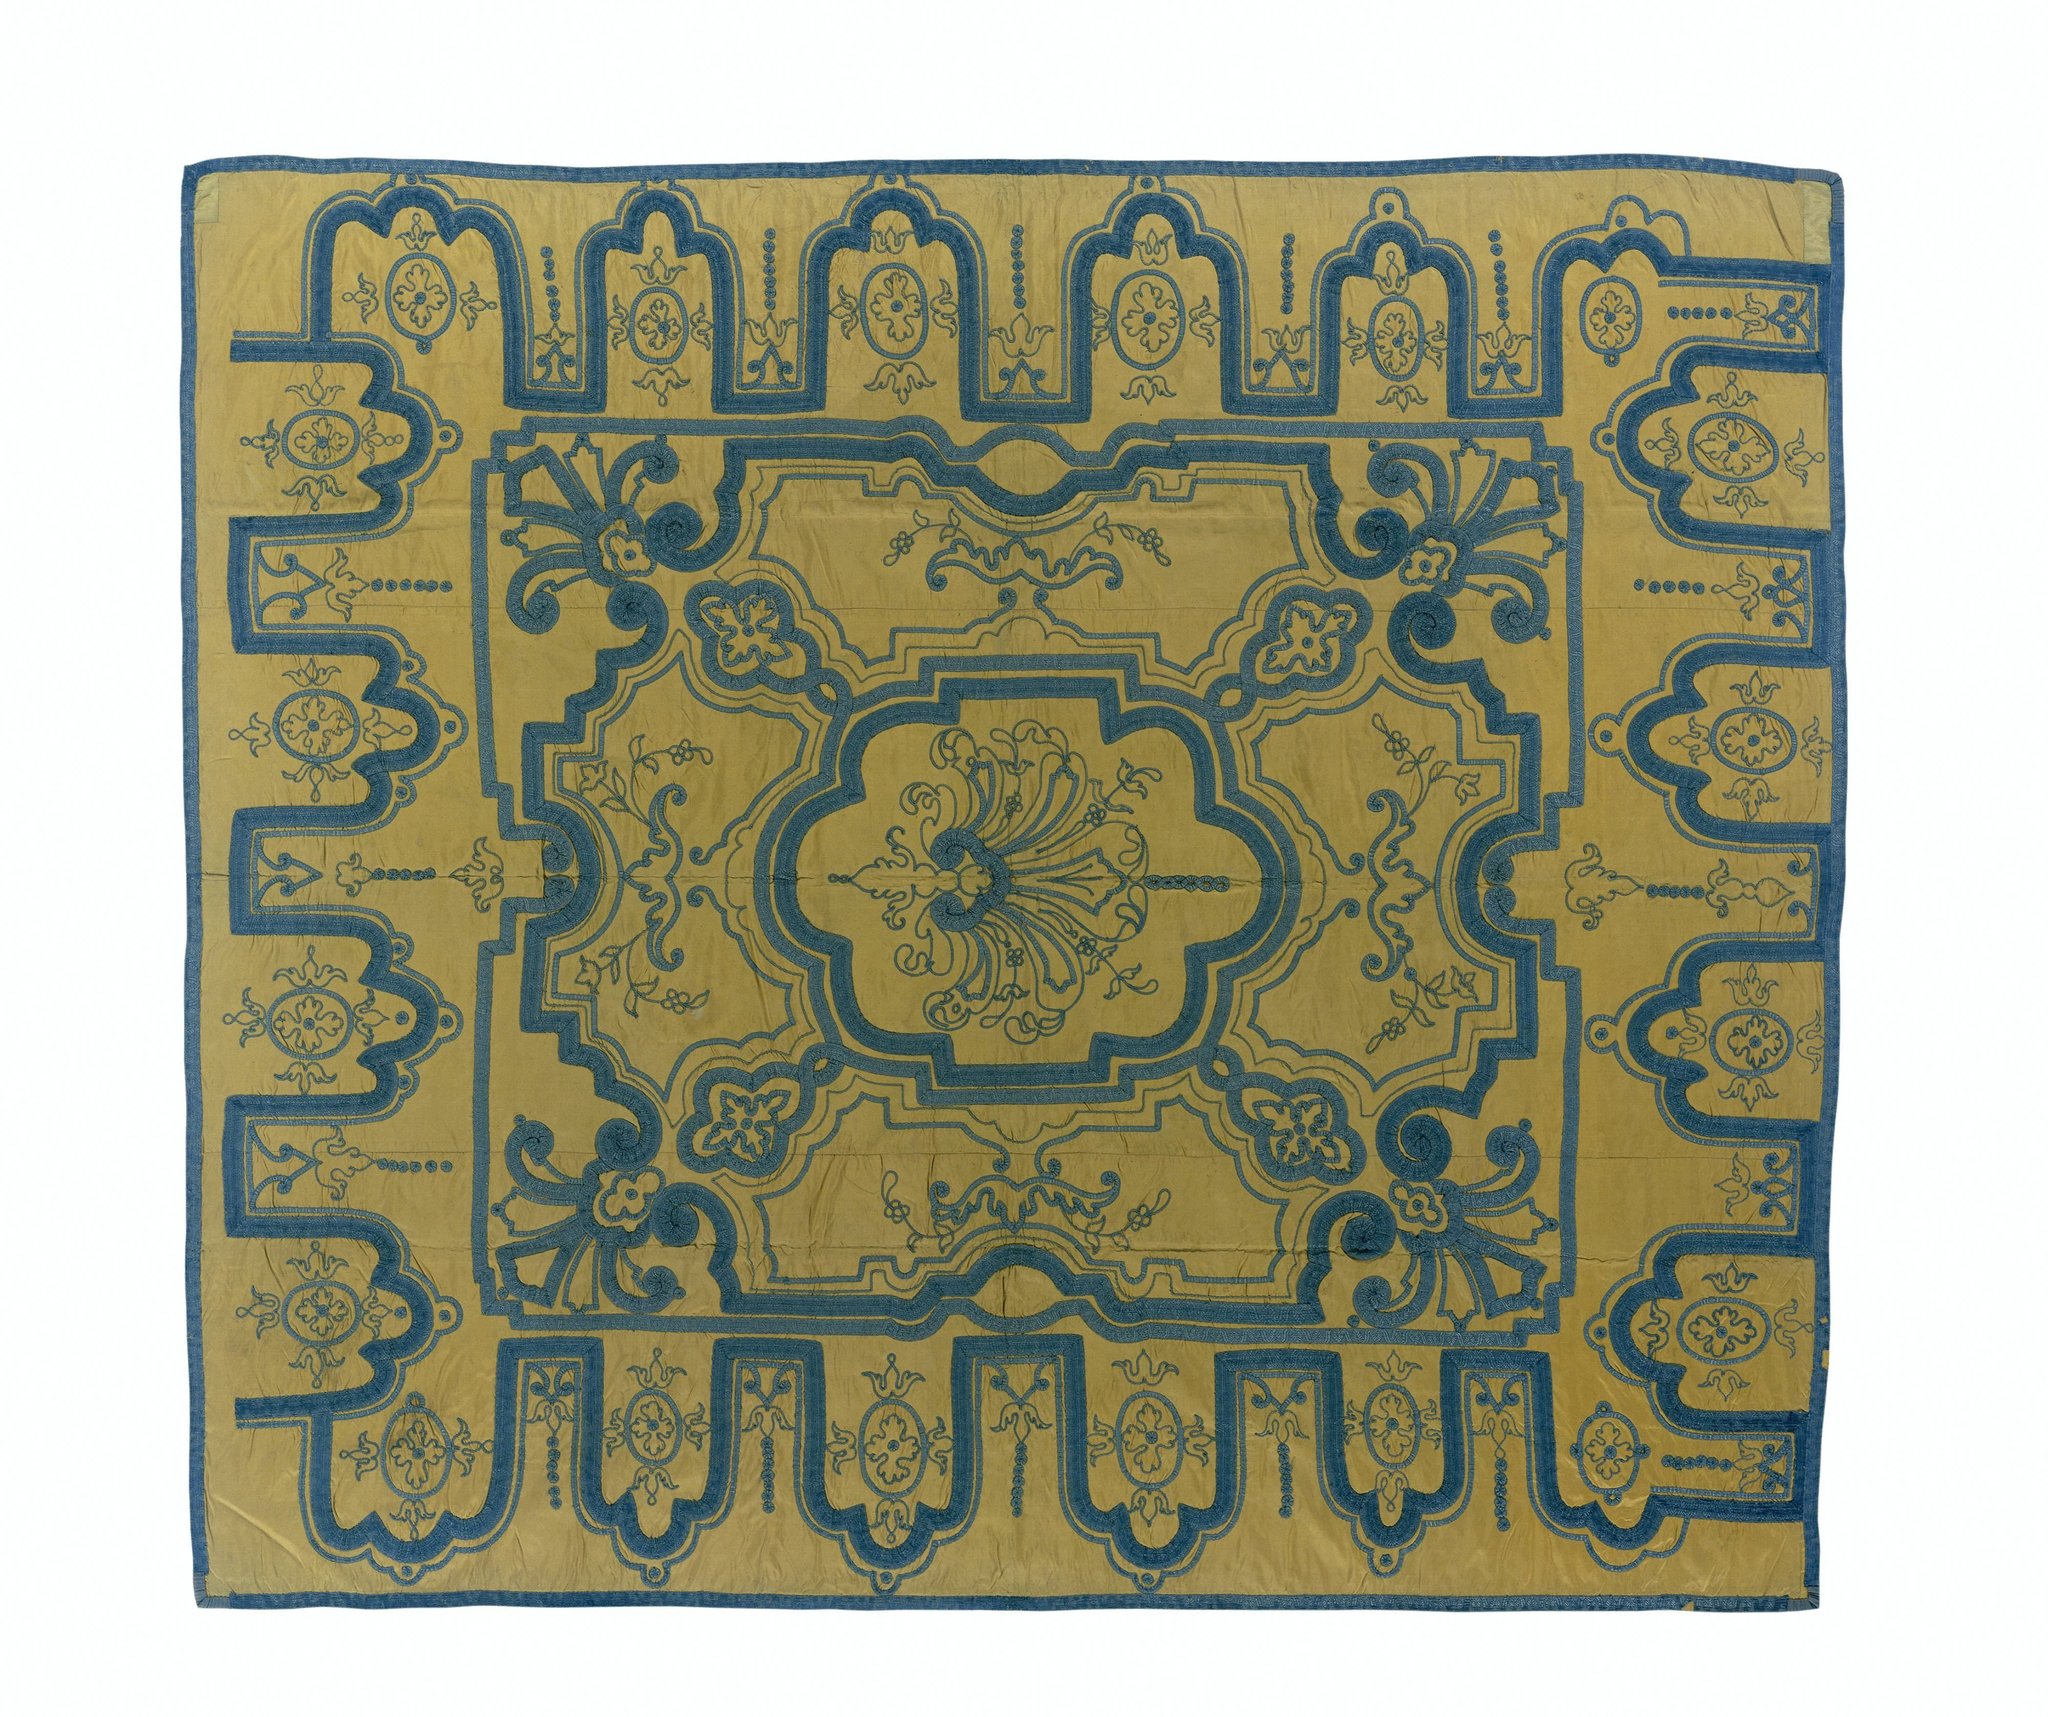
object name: bedspread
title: Sprei van gele zijde, belegd in Daniel Marot-stijl met blauw passement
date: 1700-1720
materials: silk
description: Sprei van gele zijde, belegd in Daniel Marot-stijl met blauw passement.